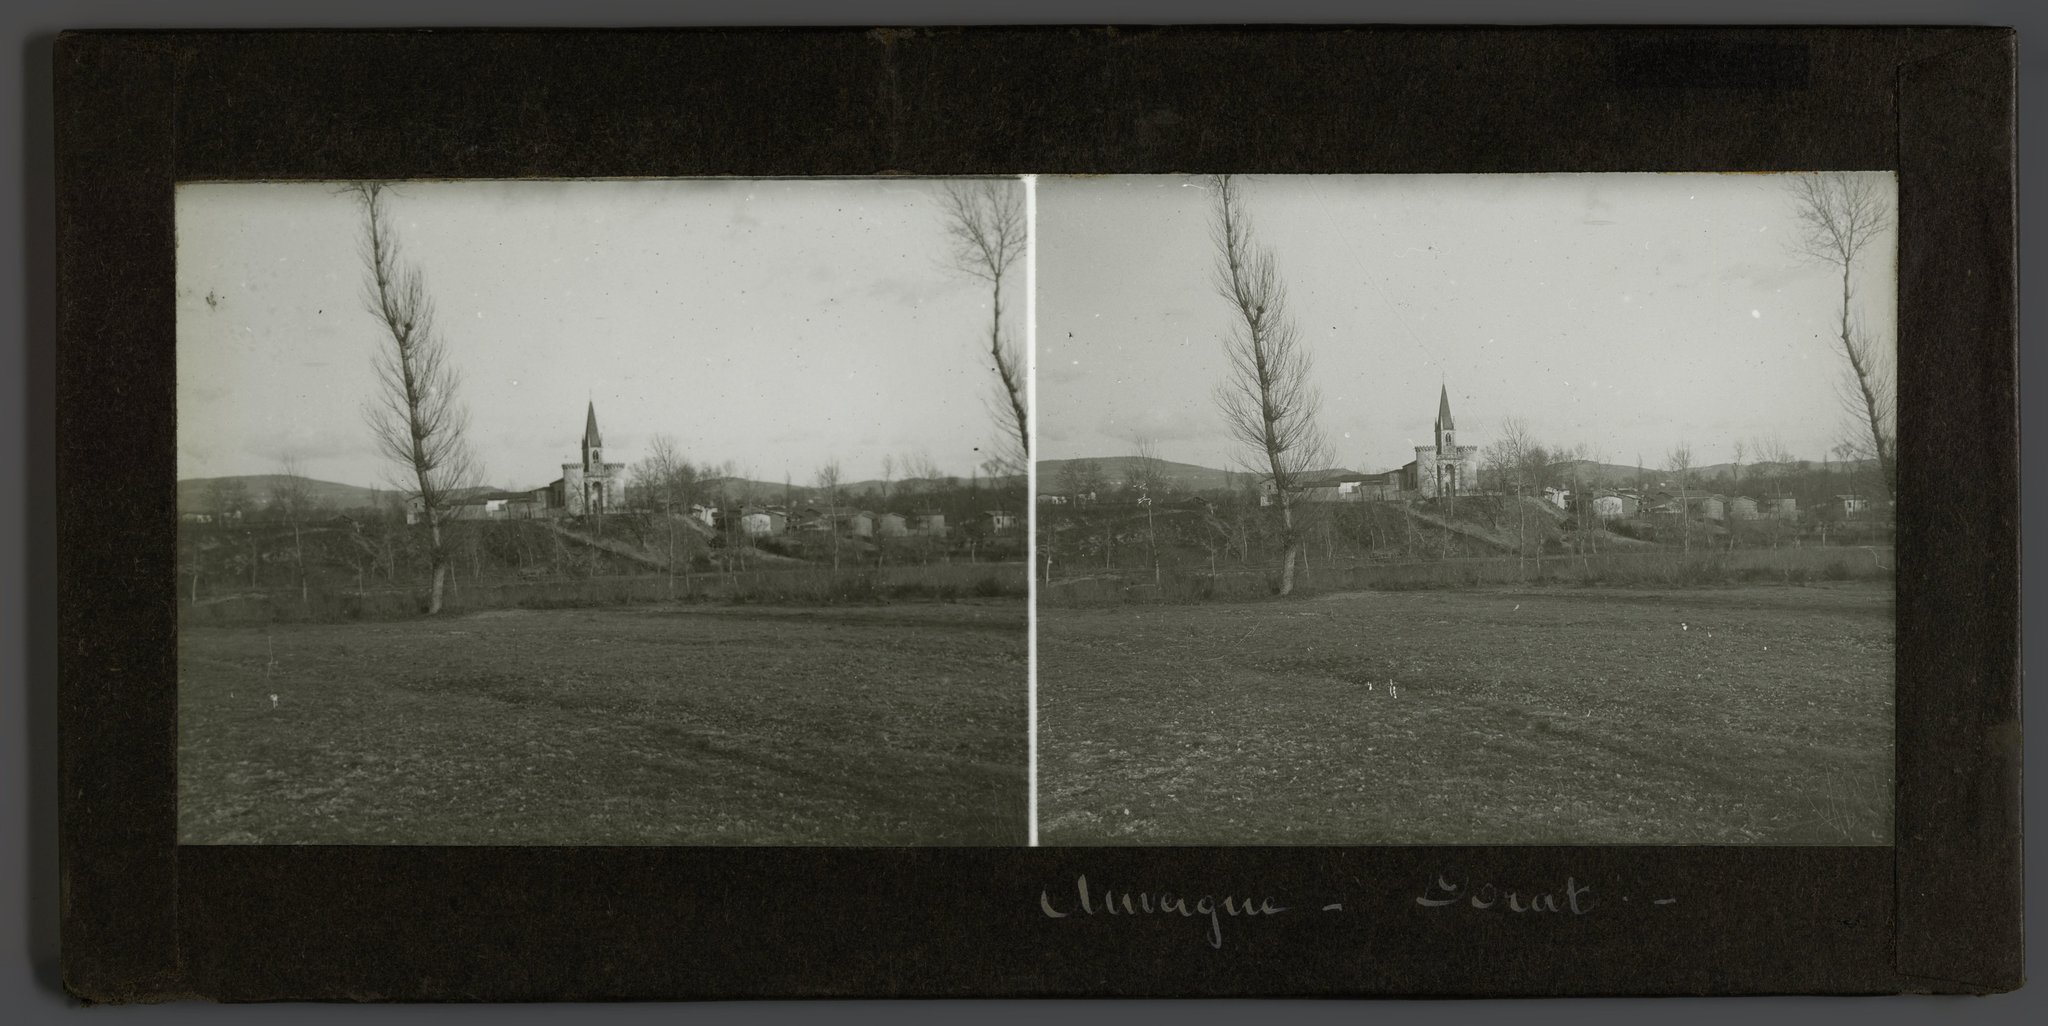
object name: stereoscopic photograph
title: Auvergne - Dorat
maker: Anonymous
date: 1860-1890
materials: glass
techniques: slide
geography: auvergne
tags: prospect of village, silhouette of village